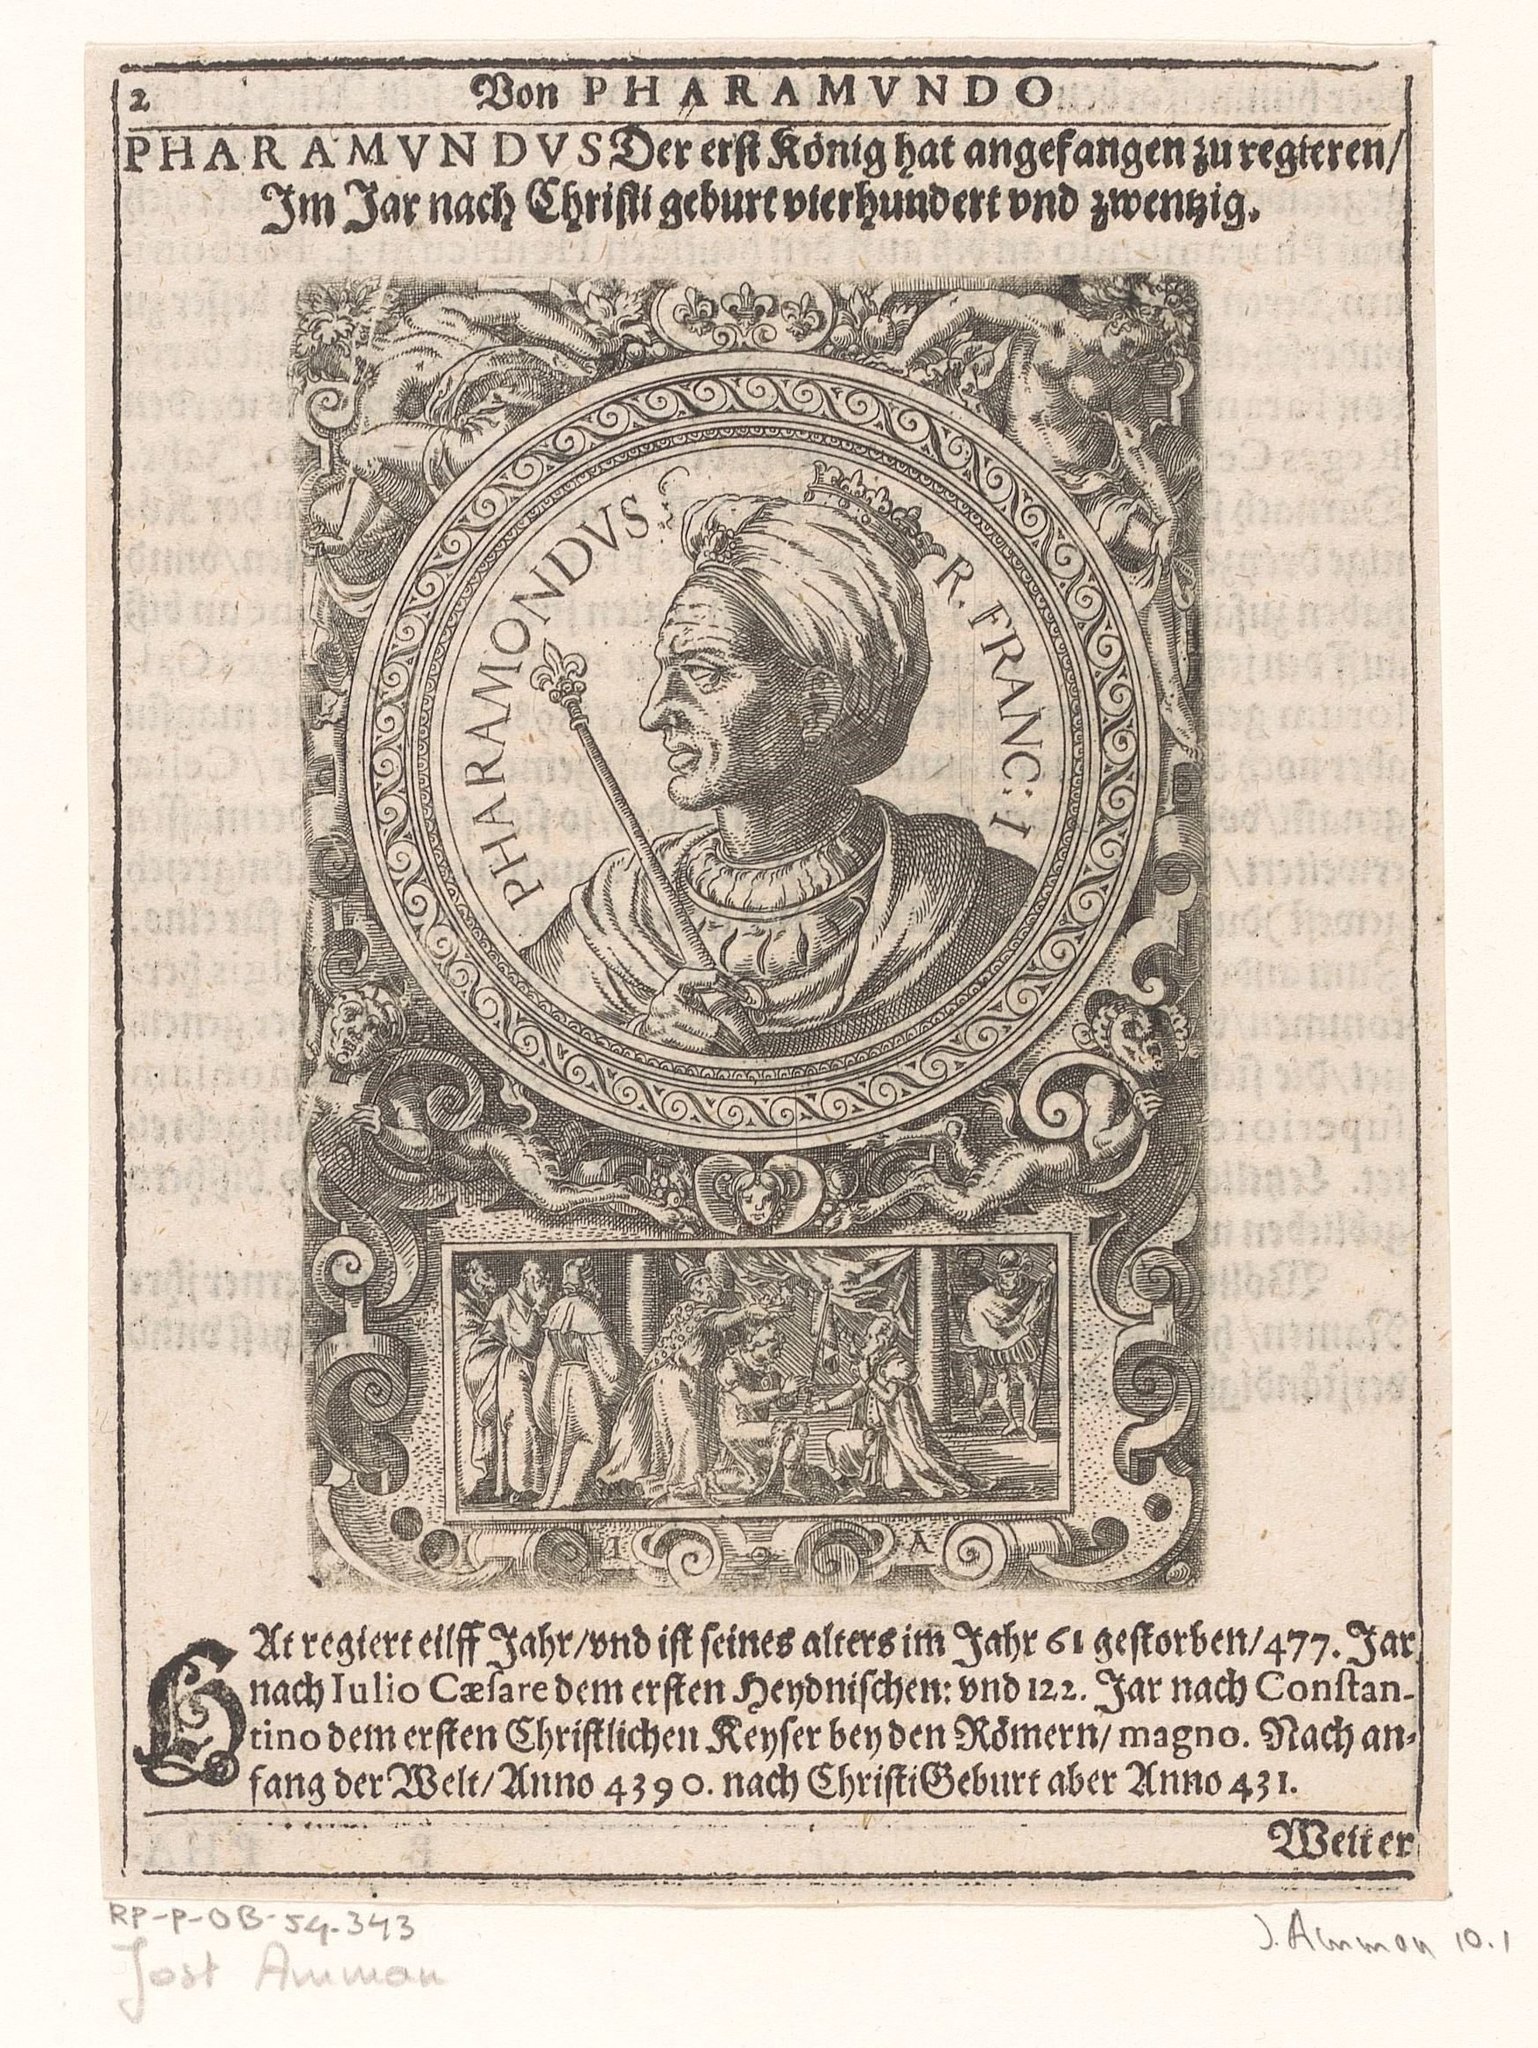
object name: print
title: Portret van Pharamond, koning der Franken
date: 1598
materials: paper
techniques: etching, intaglio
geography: nuremberg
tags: scrollwork, strapwork ~ ornament, historical persons, ruler, sovereign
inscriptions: number: ‘158’, collector's mark: Lugt 2228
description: Prent afkomstig uit de publicatie: Michael Eizinger. Könige in Frankreich. Keulen: Johann Bussemacher, 1598, p. 2. De publicatie bevat prenten van Jost Amman en Virgil Solis.